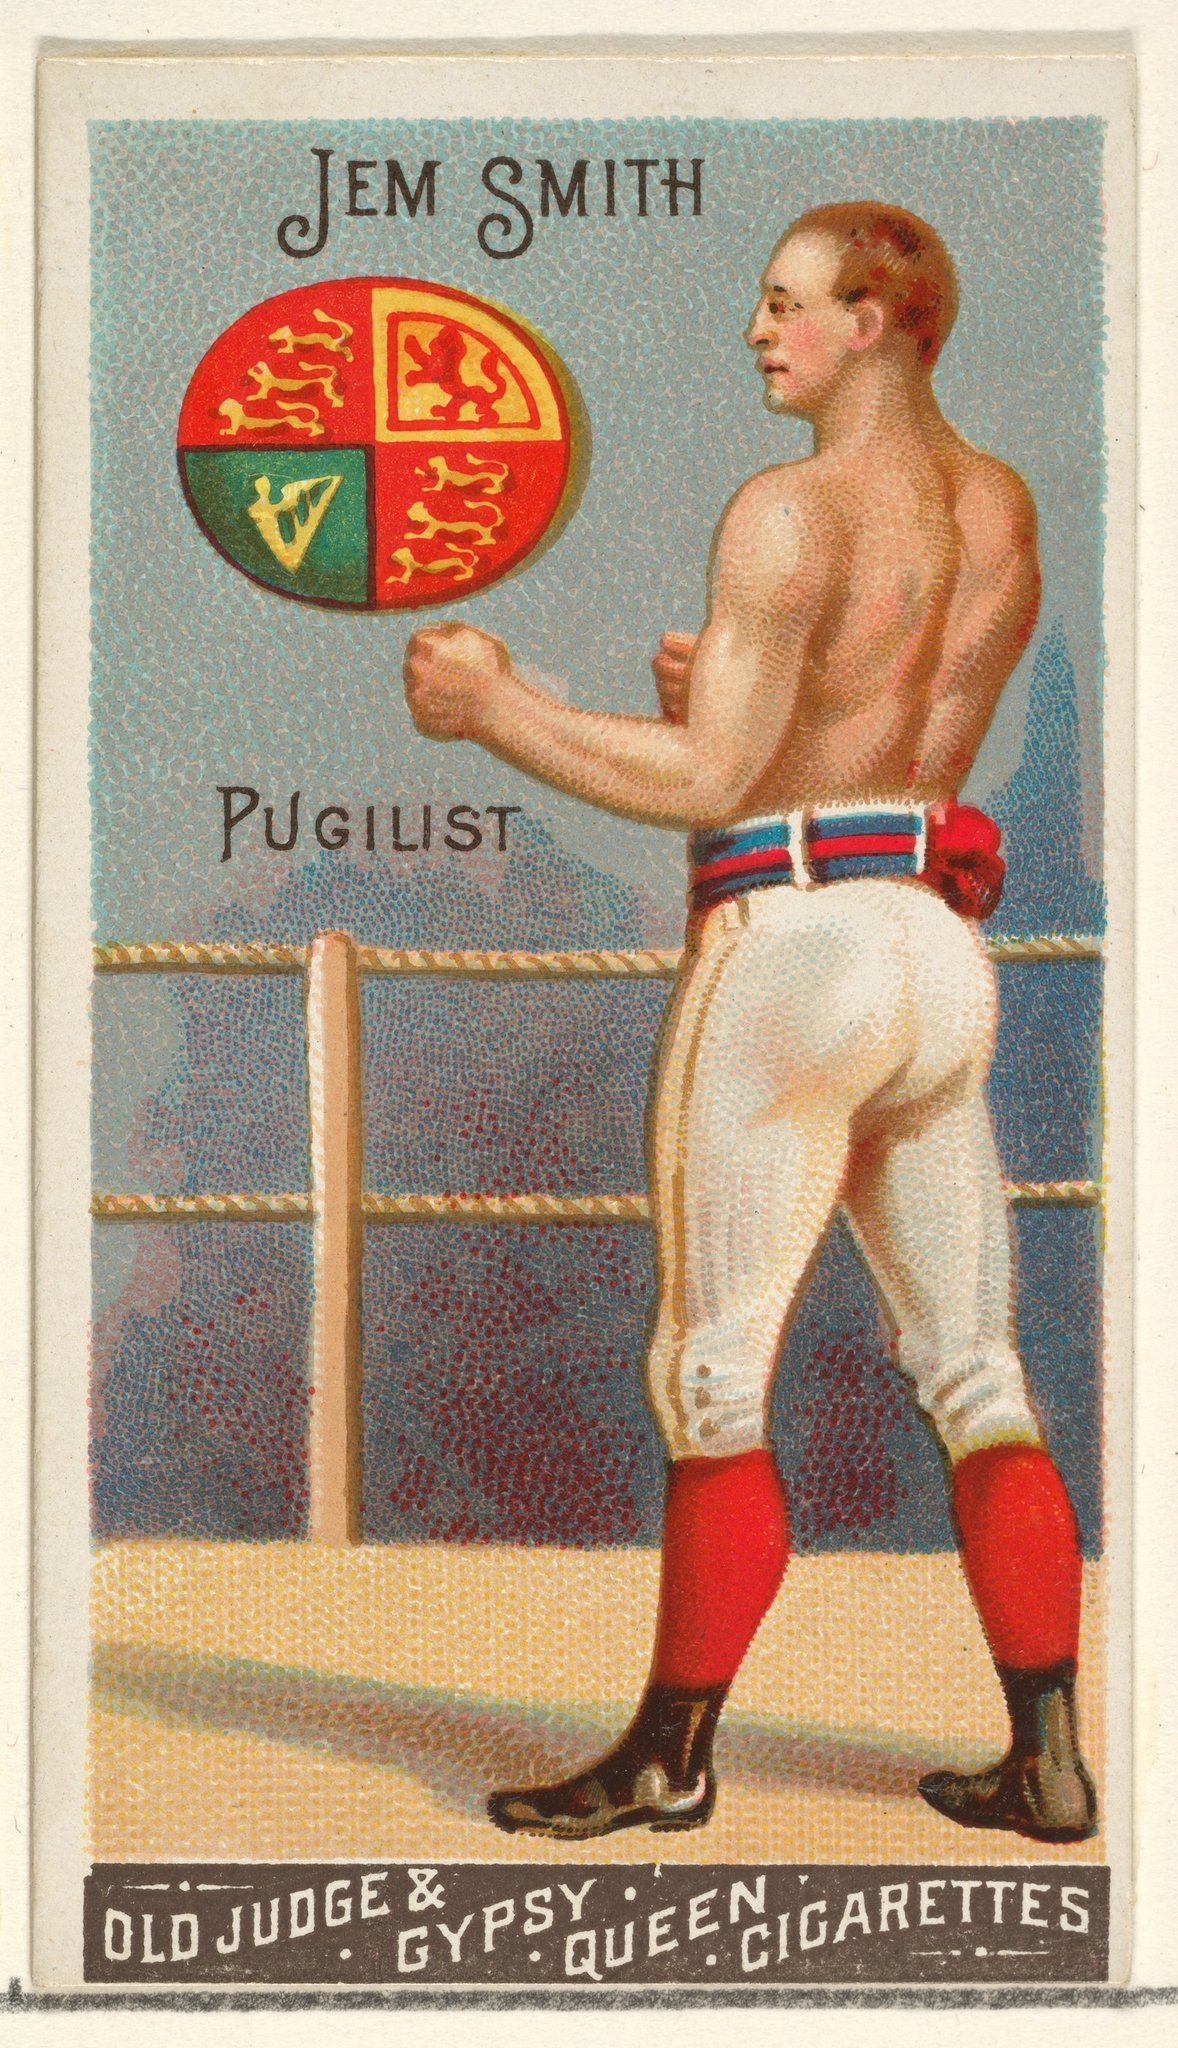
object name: print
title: Jem Smith, Pugilist, from the Goodwin Champion series for Old Judge and Gypsy Queen Cigarettes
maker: goodwin & company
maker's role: publisher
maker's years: 1850-1950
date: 1888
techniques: color lithograph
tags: men,profiles,athletes